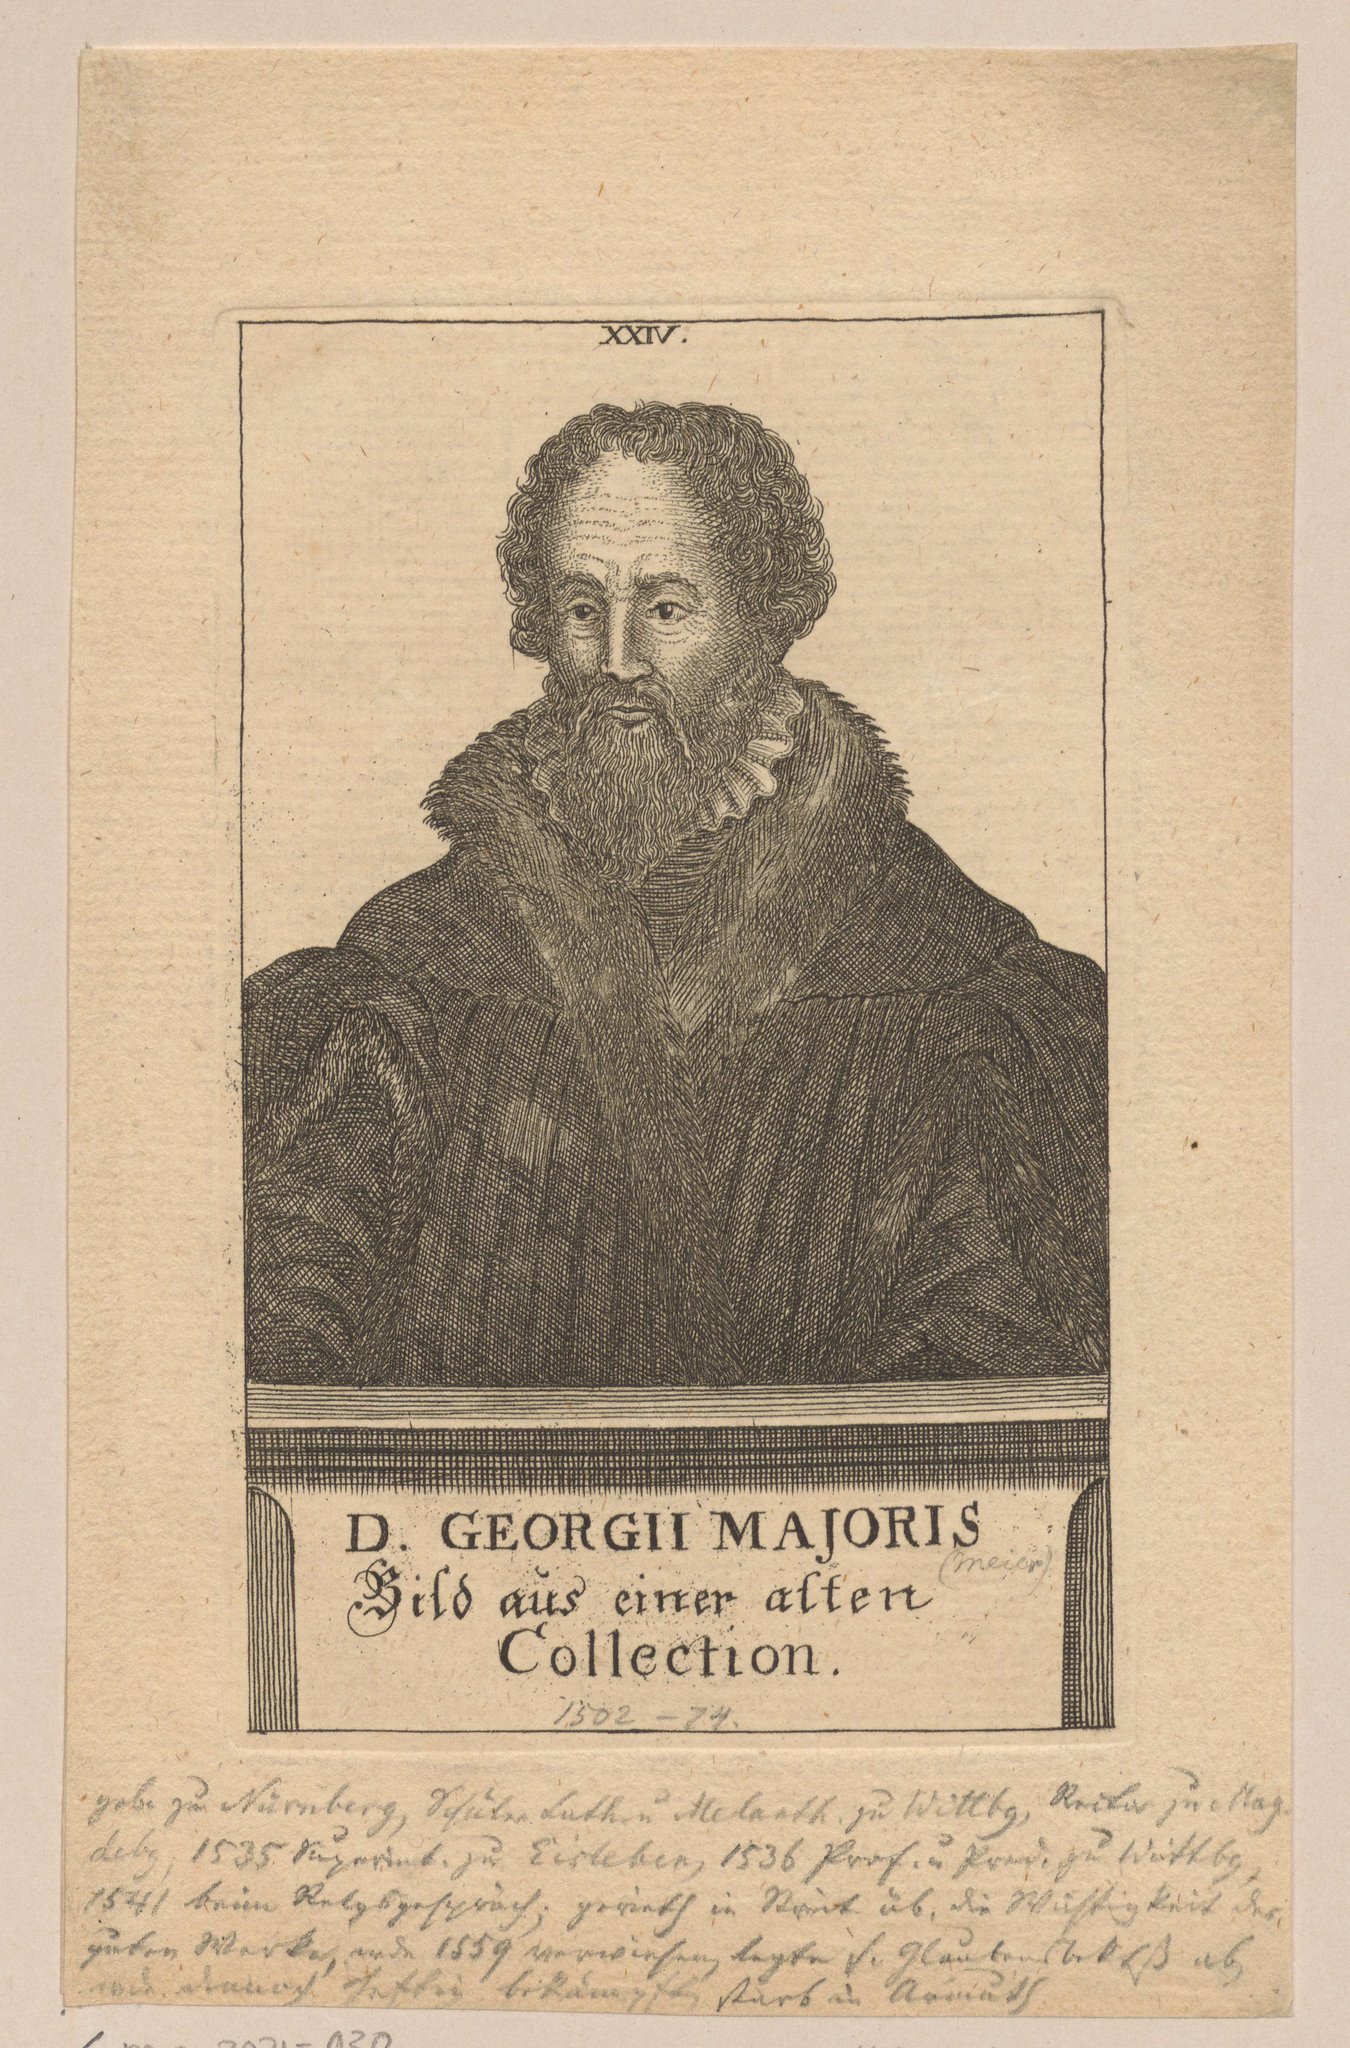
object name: print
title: Portret van Georg Major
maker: johann friedrich braun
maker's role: printer, publisher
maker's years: 1672-1721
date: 1719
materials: paper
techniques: engraving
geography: leipzig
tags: historical persons, mistress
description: Prent uit: Unschuldige Nachrichten Von Alten und Neuen Theologischen Sachen. Leipzig: Johann Friedrich Braun, 1719.